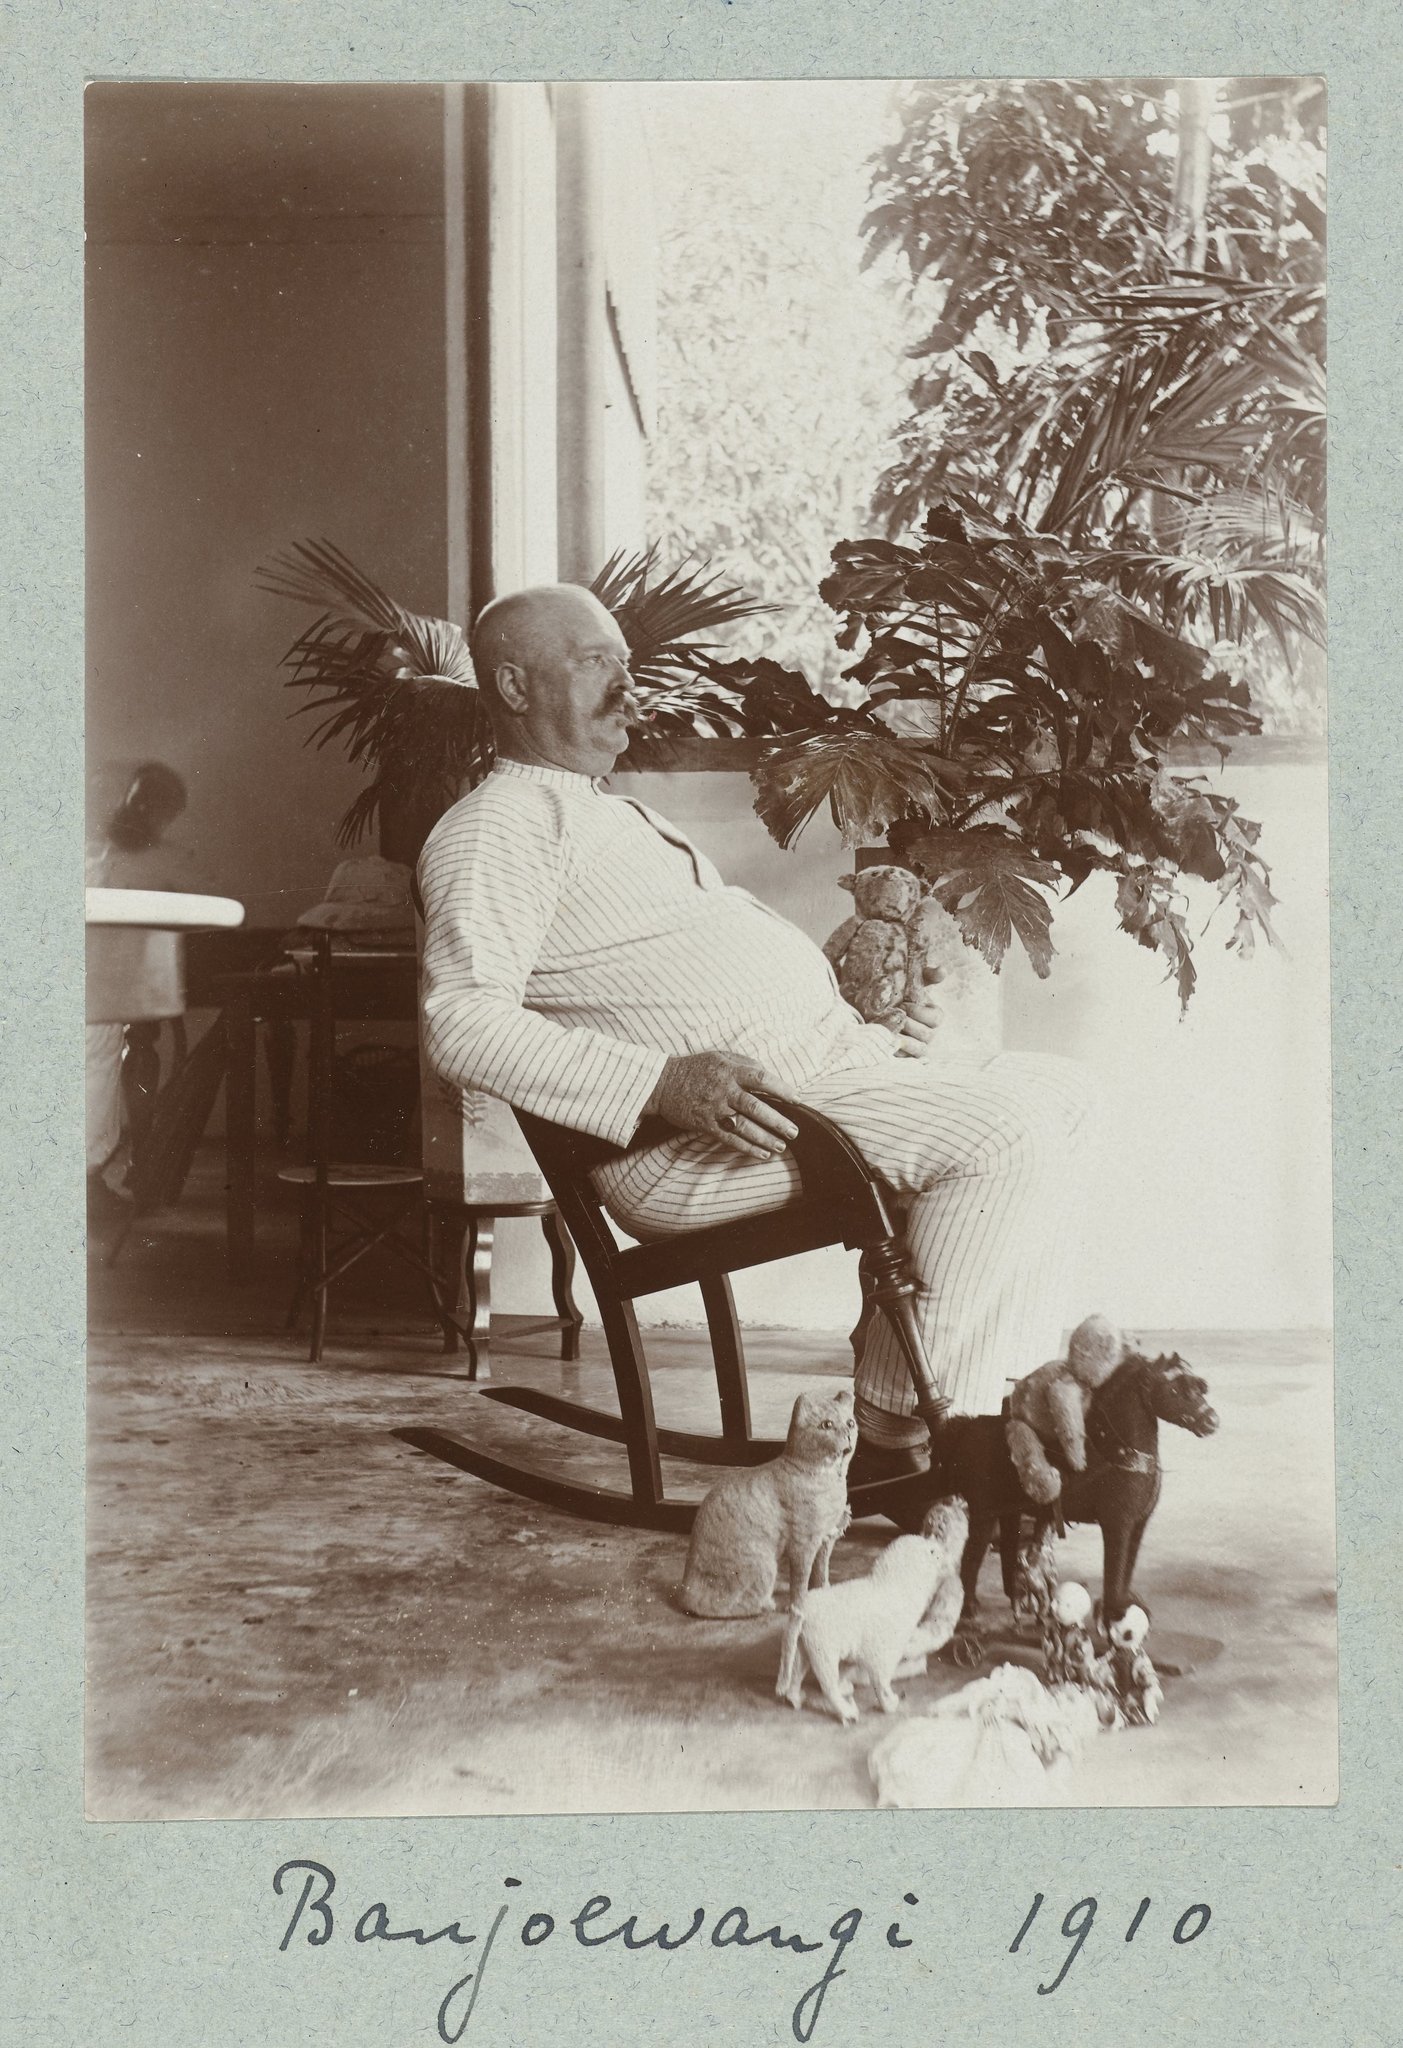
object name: photograph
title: Banjoewangi 1910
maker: frits freerks fontein fz.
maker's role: fotograaf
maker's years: 1882-1928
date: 1910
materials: cardboard, paper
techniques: gelatin silver print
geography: netherlands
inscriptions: caption: ‘Banjoewangi 1910’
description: De mannen dragen witte tropenuniformen waarvan een man met tropenhelm, twee andere mannen dragen een strooien hoed, de vrouwen dragen witte jurken of batik rokken met witte hes. Foto uit album 'Photographieën".